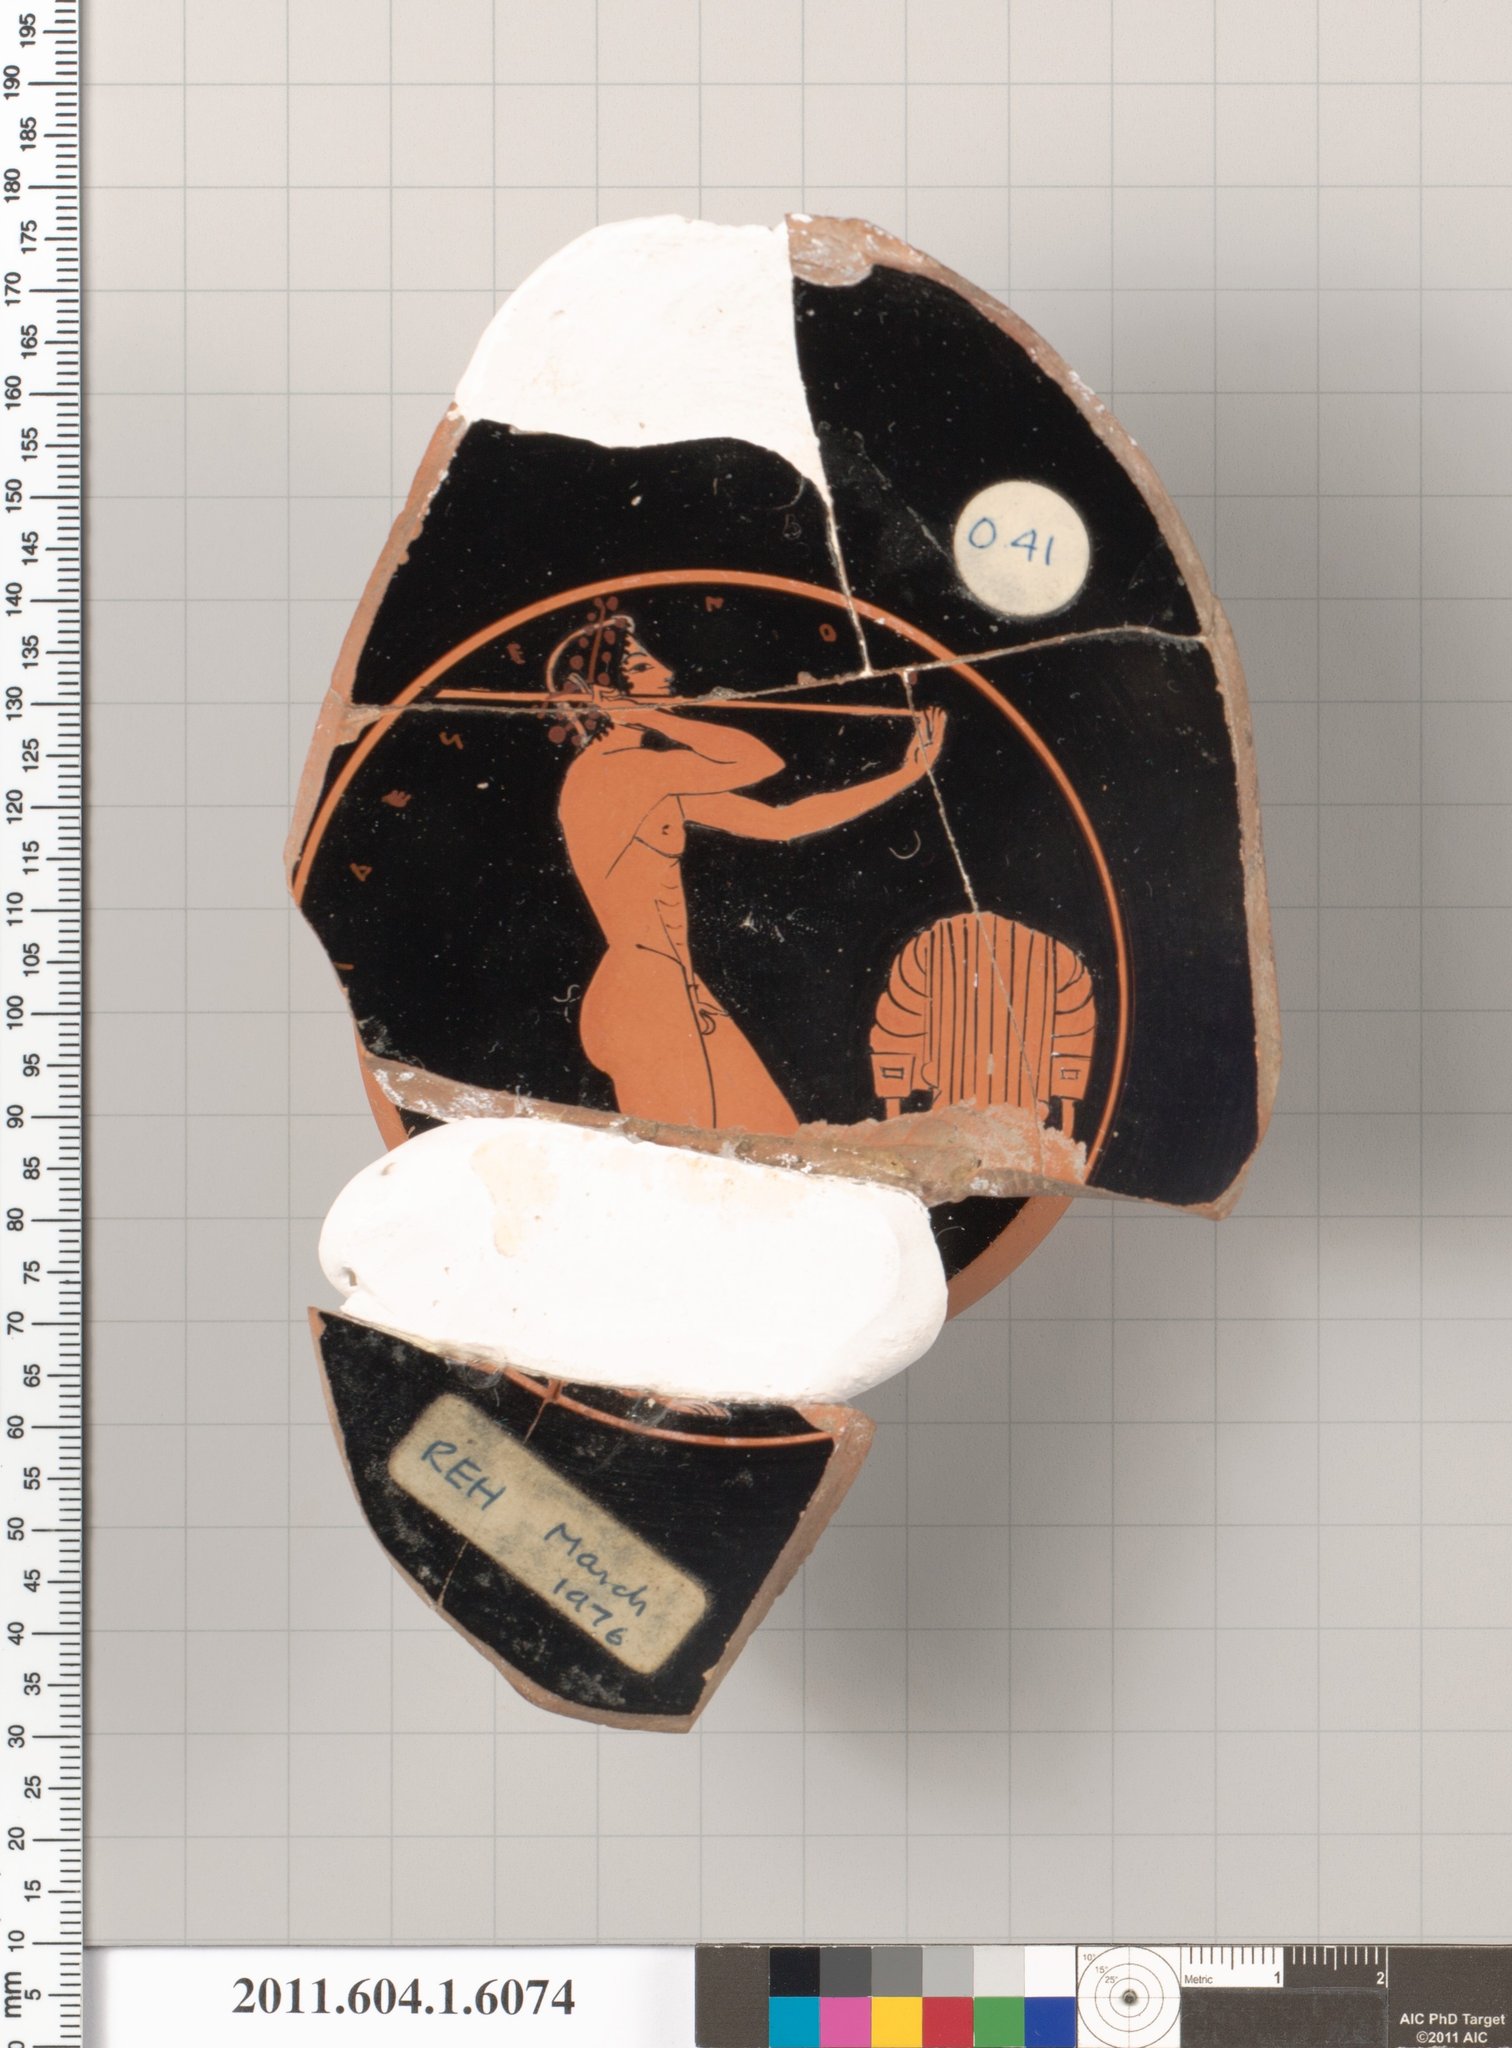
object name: kylix fragment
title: Terracotta fragment of a kylix (drinking cup)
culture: greek, attic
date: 510-500 BCE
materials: terracotta